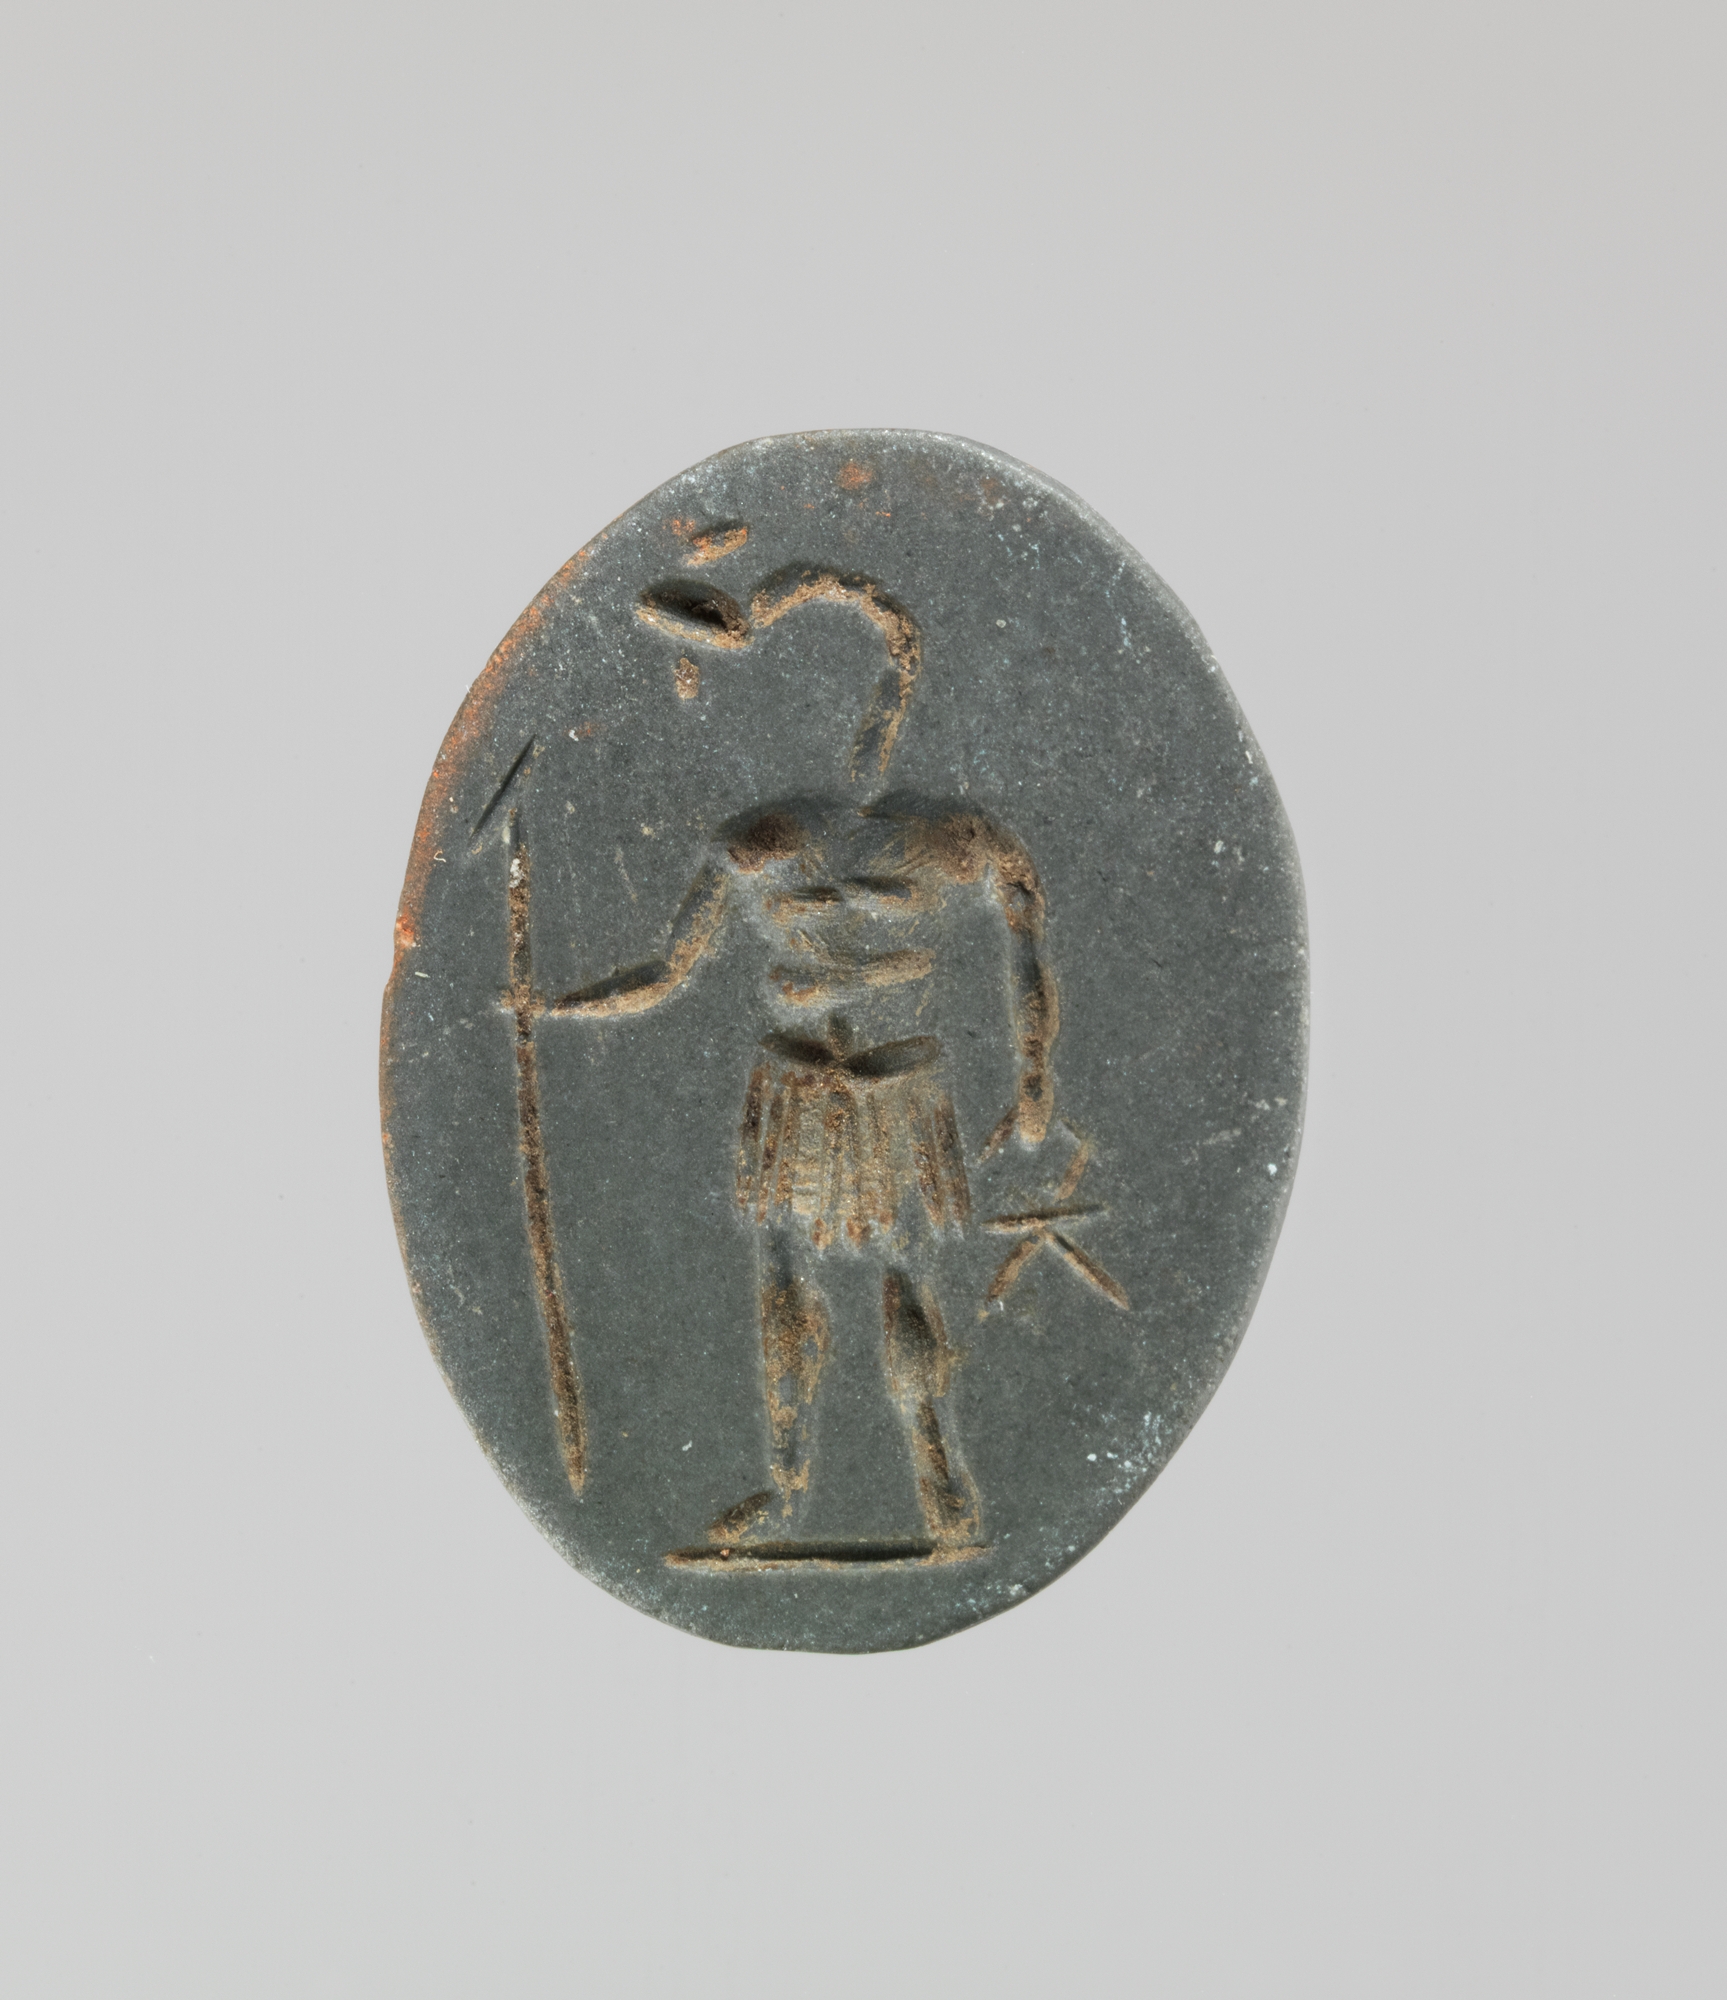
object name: intaglio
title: Ironstone intaglio: Snake-headed Genius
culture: roman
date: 101-200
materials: stone